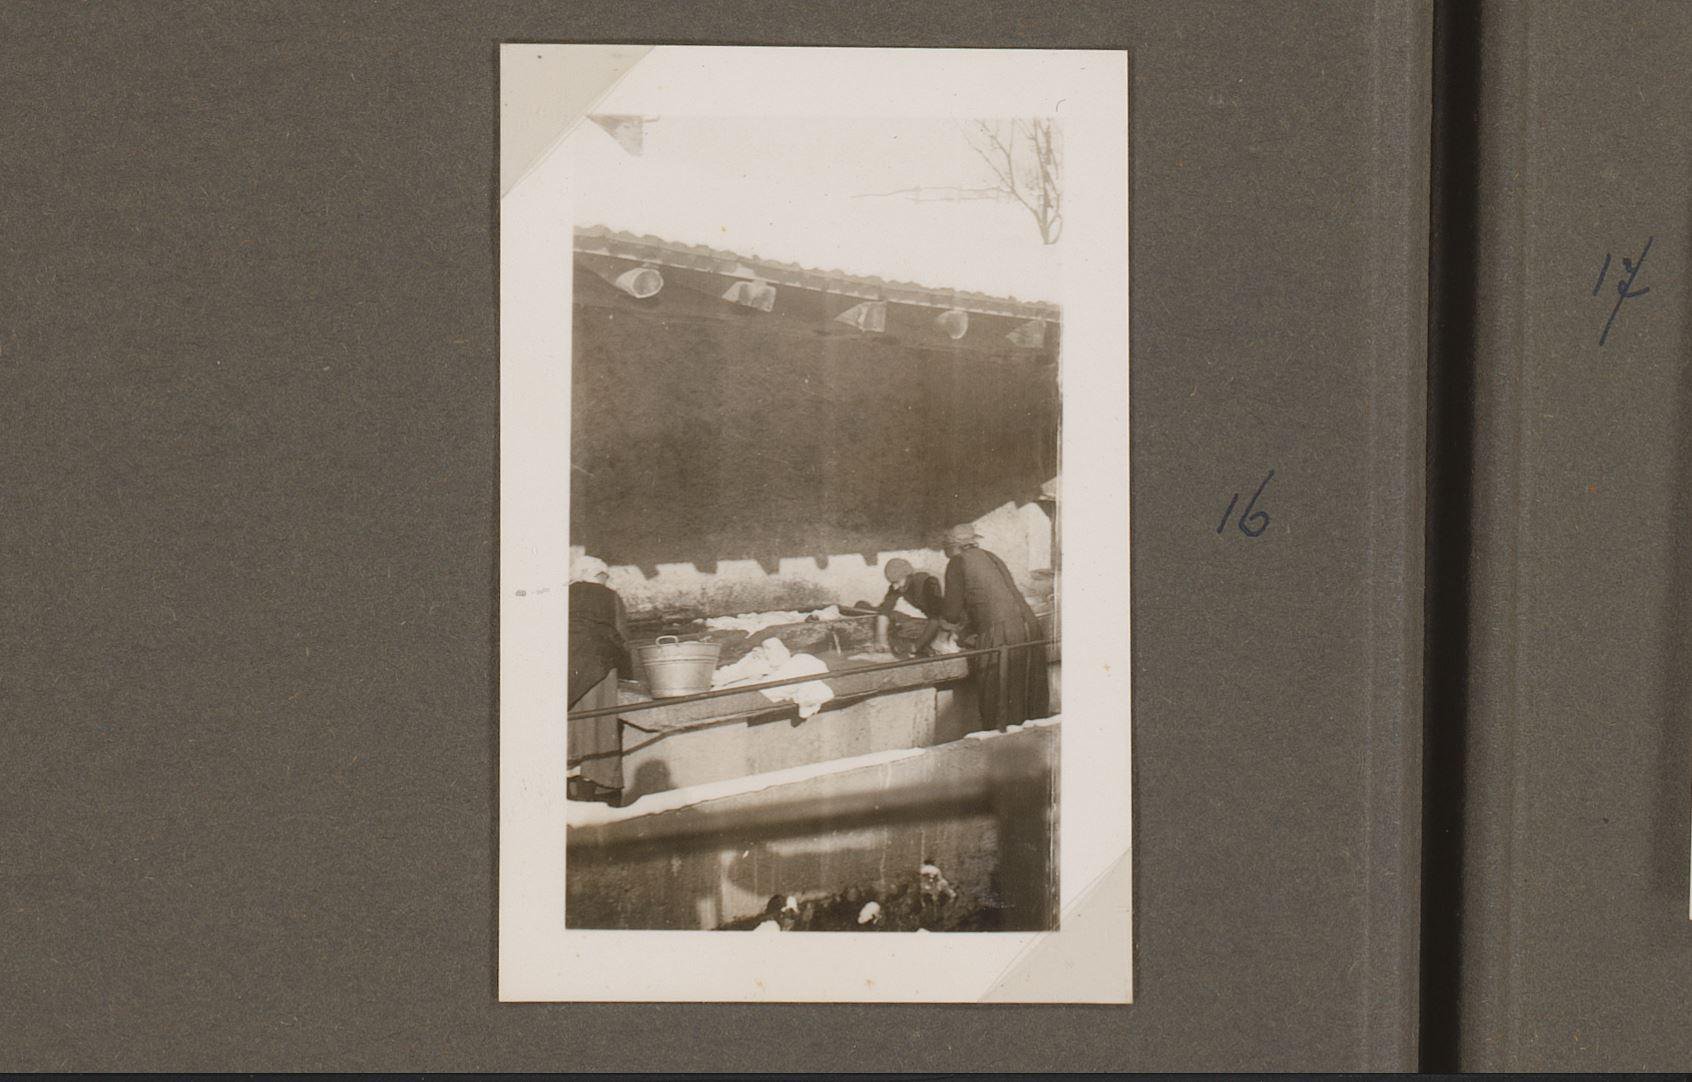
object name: album leaf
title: Twee vrouwen doen de was in Odogno, Zwitserland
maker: Anonymous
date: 1933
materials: photographic support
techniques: gelatin silver print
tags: public wash house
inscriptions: number: ‘16’